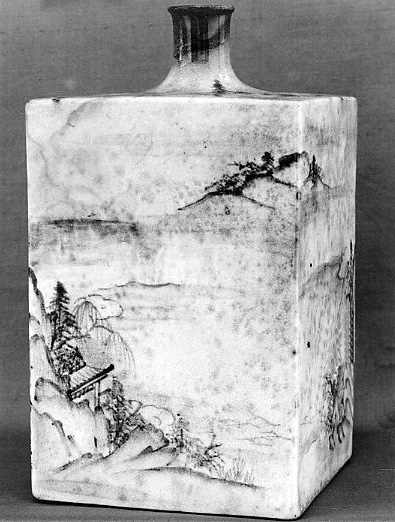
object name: bottle, square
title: Square Bottle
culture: japanese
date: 1701-1800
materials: glaze, pottery